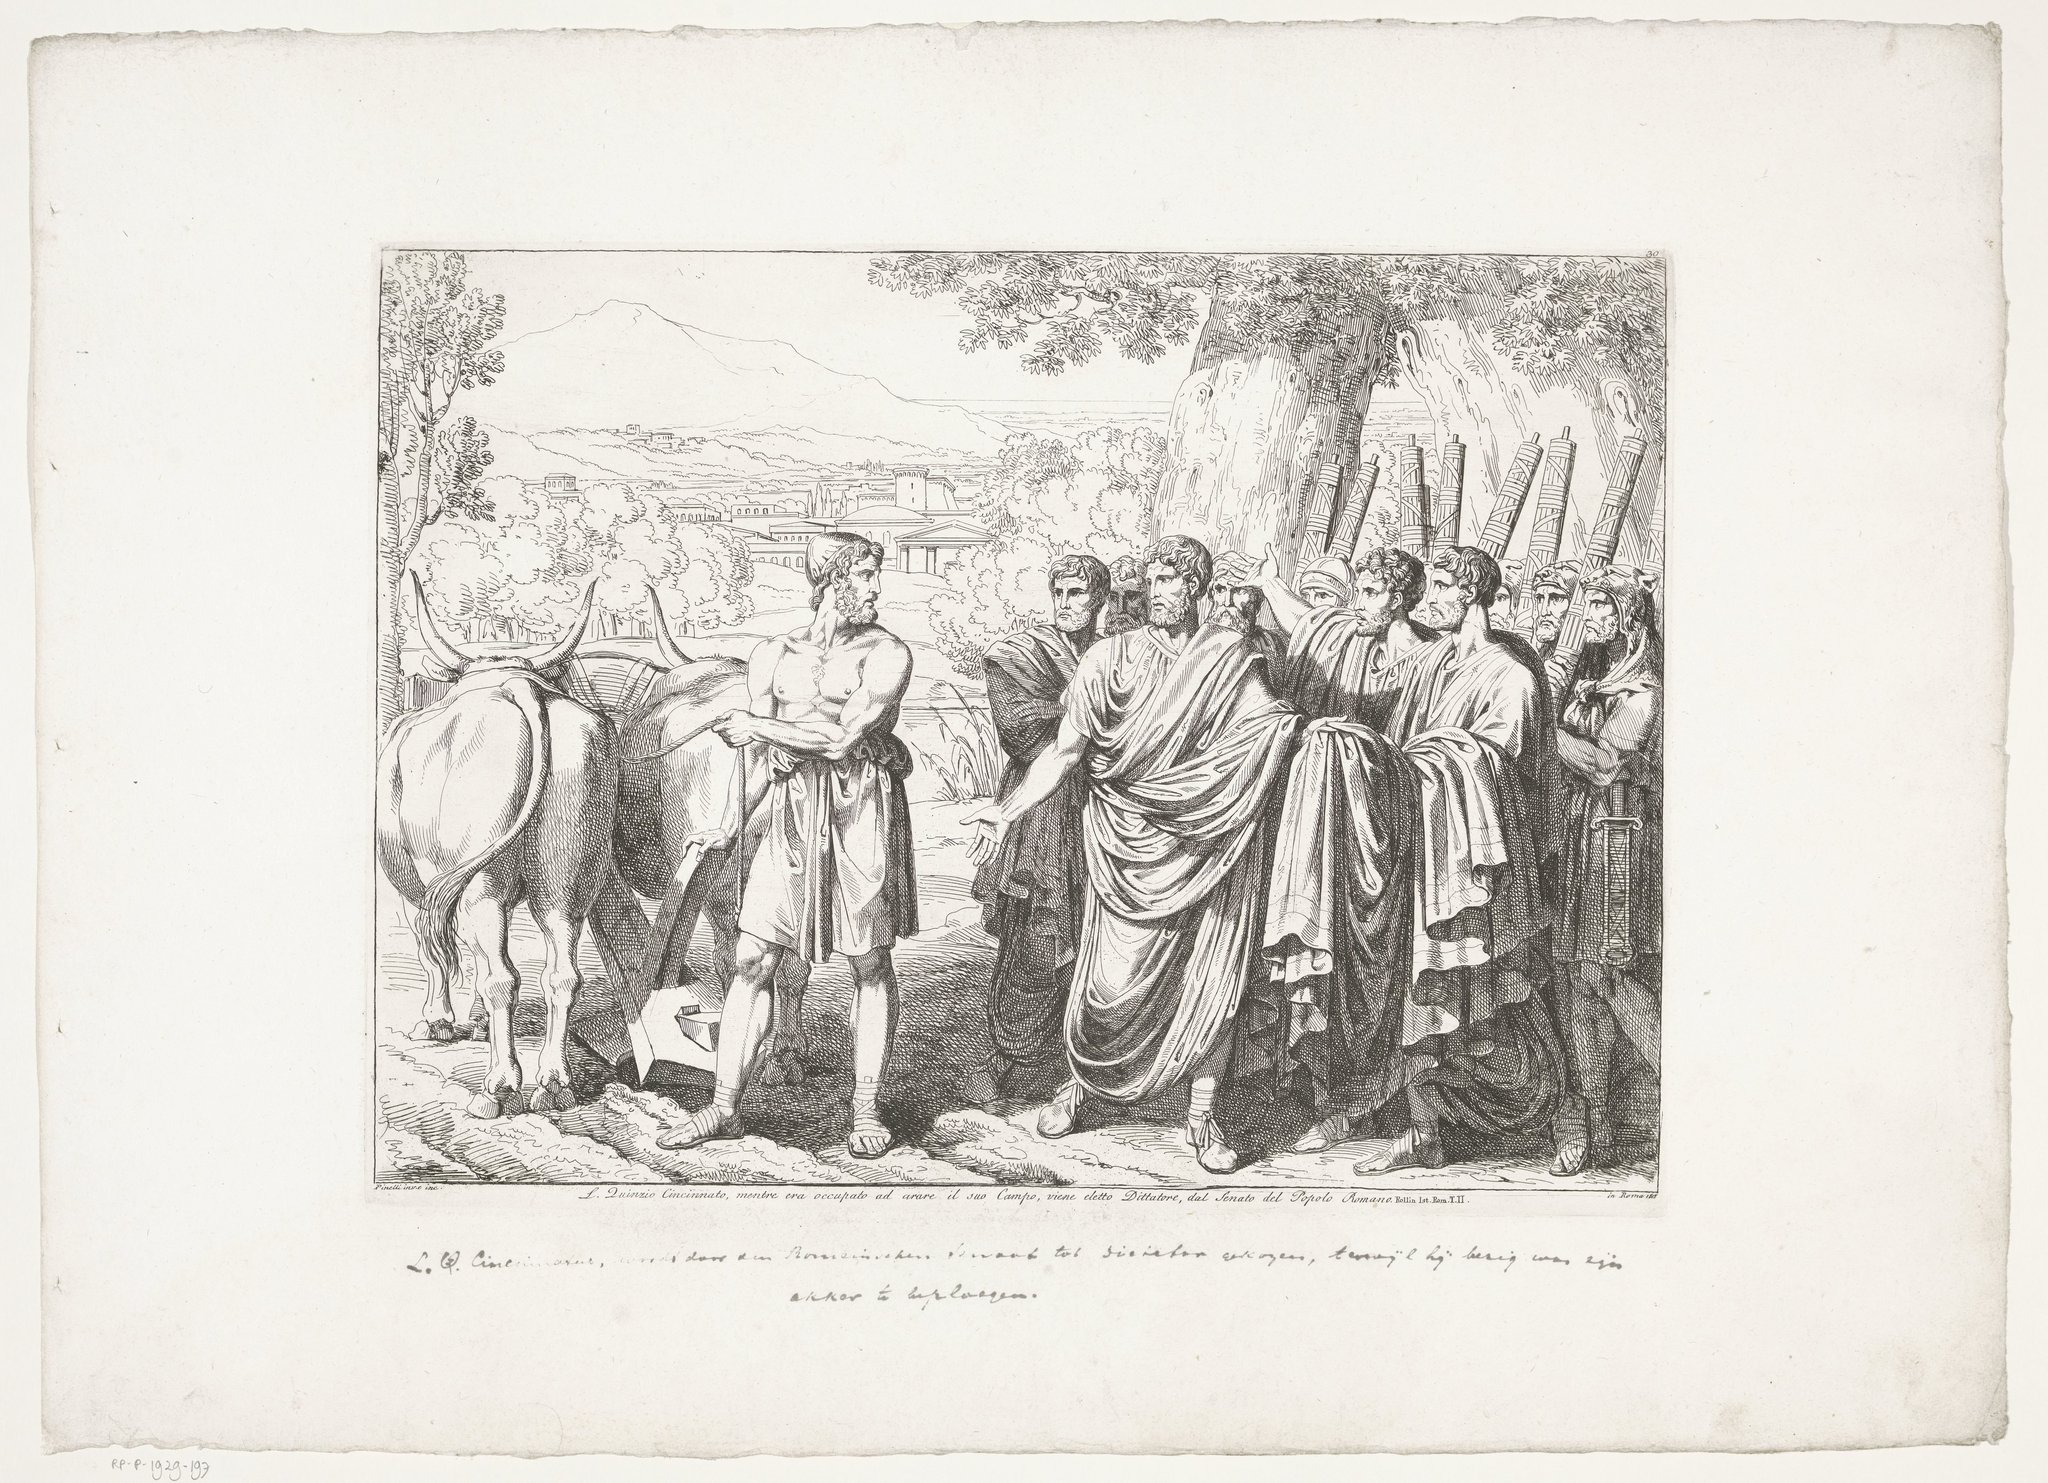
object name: print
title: Geschiedenis van het Romeinse Rijk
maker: bartolomeo pinelli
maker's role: draughtsman, print maker, sculptor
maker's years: 1781-1835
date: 1818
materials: paper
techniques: etching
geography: rome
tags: lucius quinctius cincinnatus is called from the plough to the dictatorship of rome; a roman embassy offers him a sword or a baton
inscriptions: collector's mark: Lugt 2228, inscription: ‘L. Q. Cincinnatus, wordt door den Romeinschen [...], terwijl hij bezig was zijn / akker te ploegen.’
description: Lucius Quintius Cincinnatus wordt tijdens het ploegen van het veld aangesproken door een groep Romeinse senatoren die hem tot dictator willen benoemen.